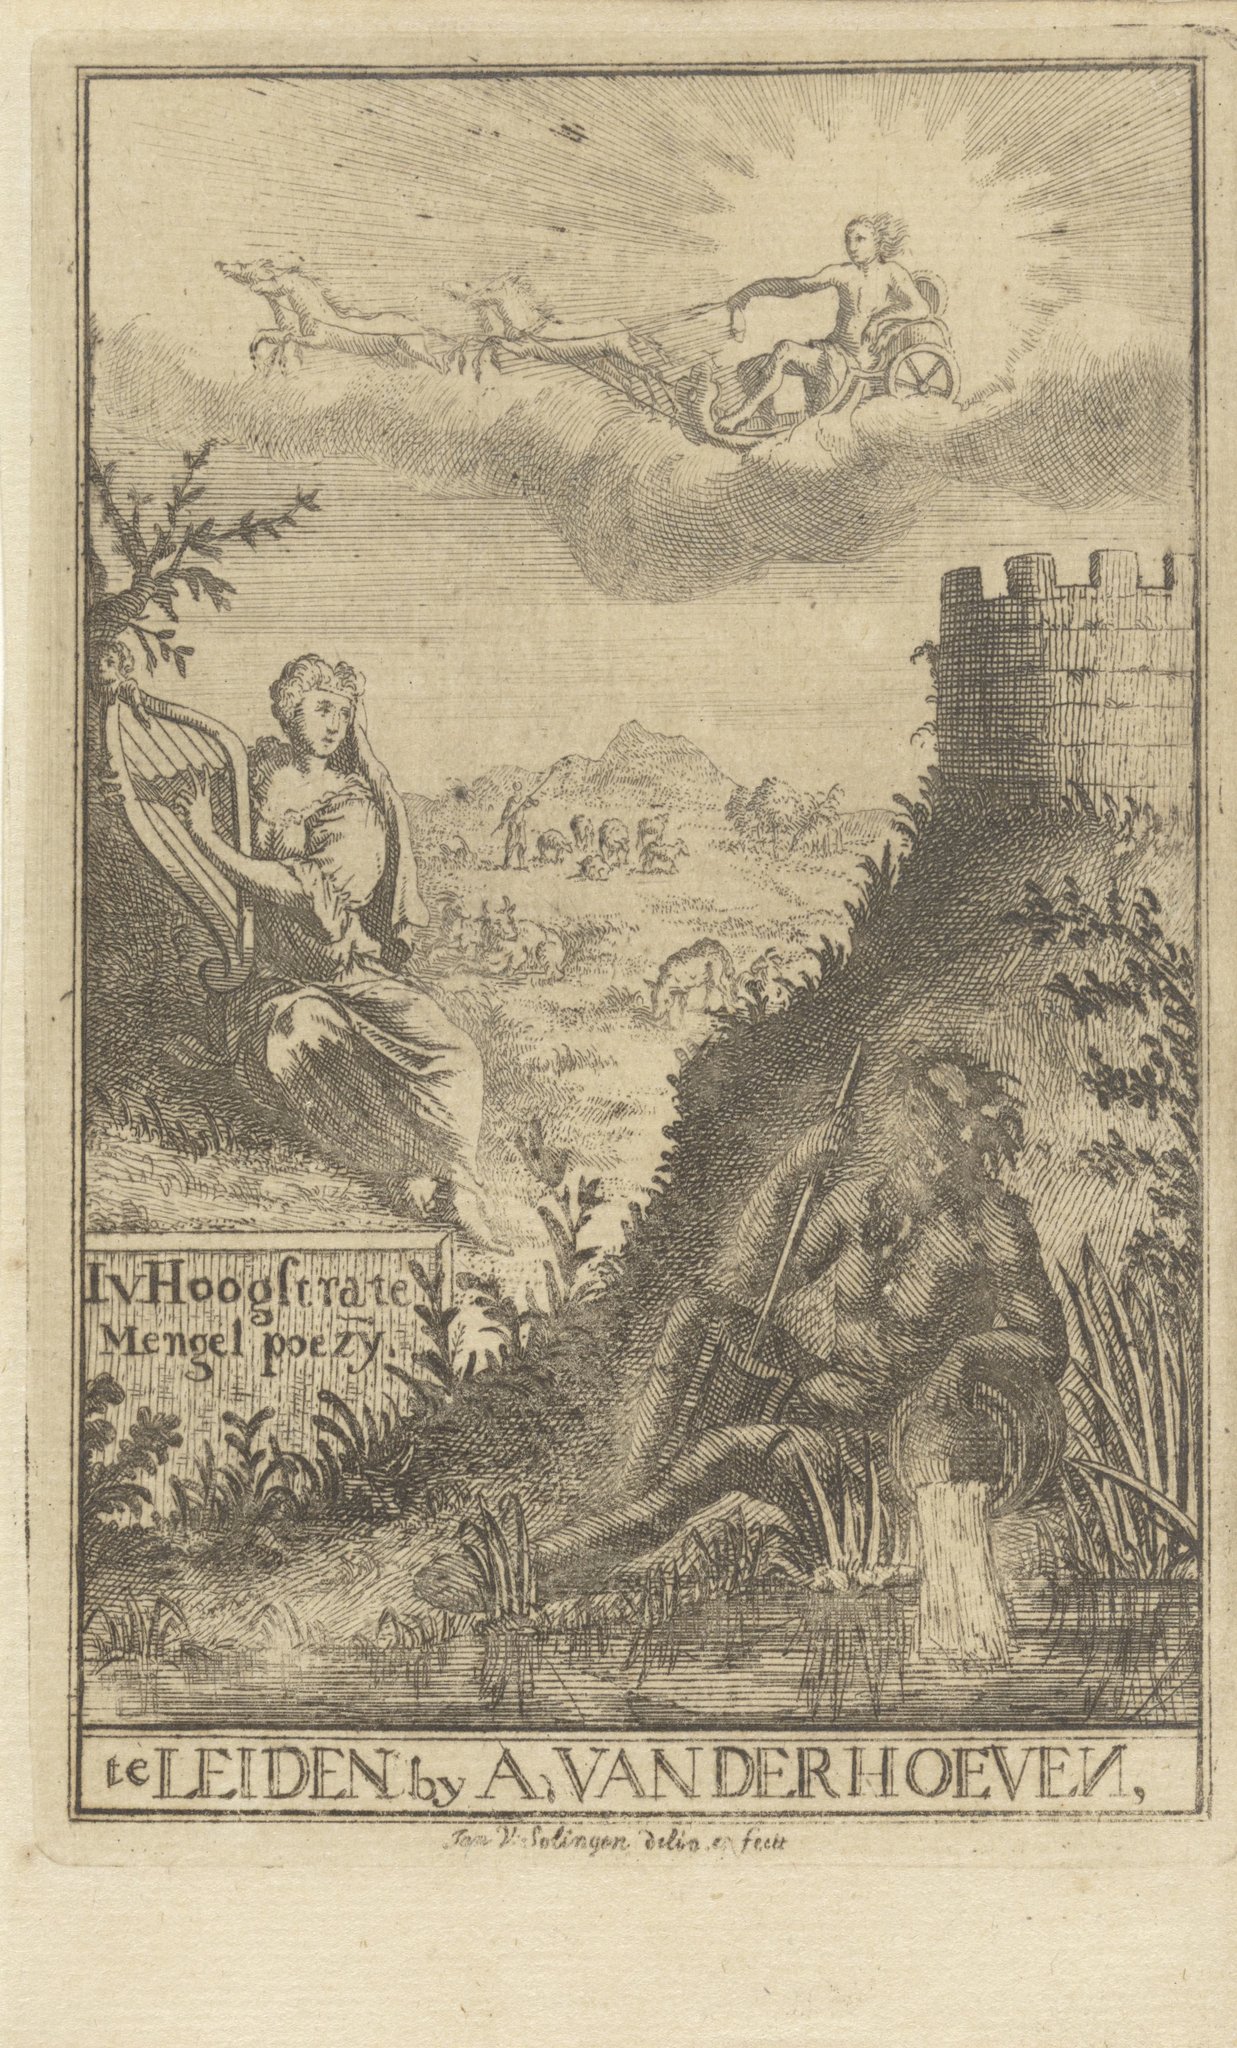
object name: print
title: Gegraveerde titelpagina voor: Jan van Hoogstraten, Vervolg of Toegift der laetste mengelpoezy, 1732.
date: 1732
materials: paper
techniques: etching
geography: leiden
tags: (story of) apollo (phoebus), river-gods, single muses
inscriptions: collector's mark: Lugt 2228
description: Allegorische voorstelling met een riviergod en een muze in een arcadische landschap met een burcht op een heuvel. Daarboven rijdt Apollo in zijn wagen. Op een muurtje de titel en auteur van het boek, onder aan het impressum.